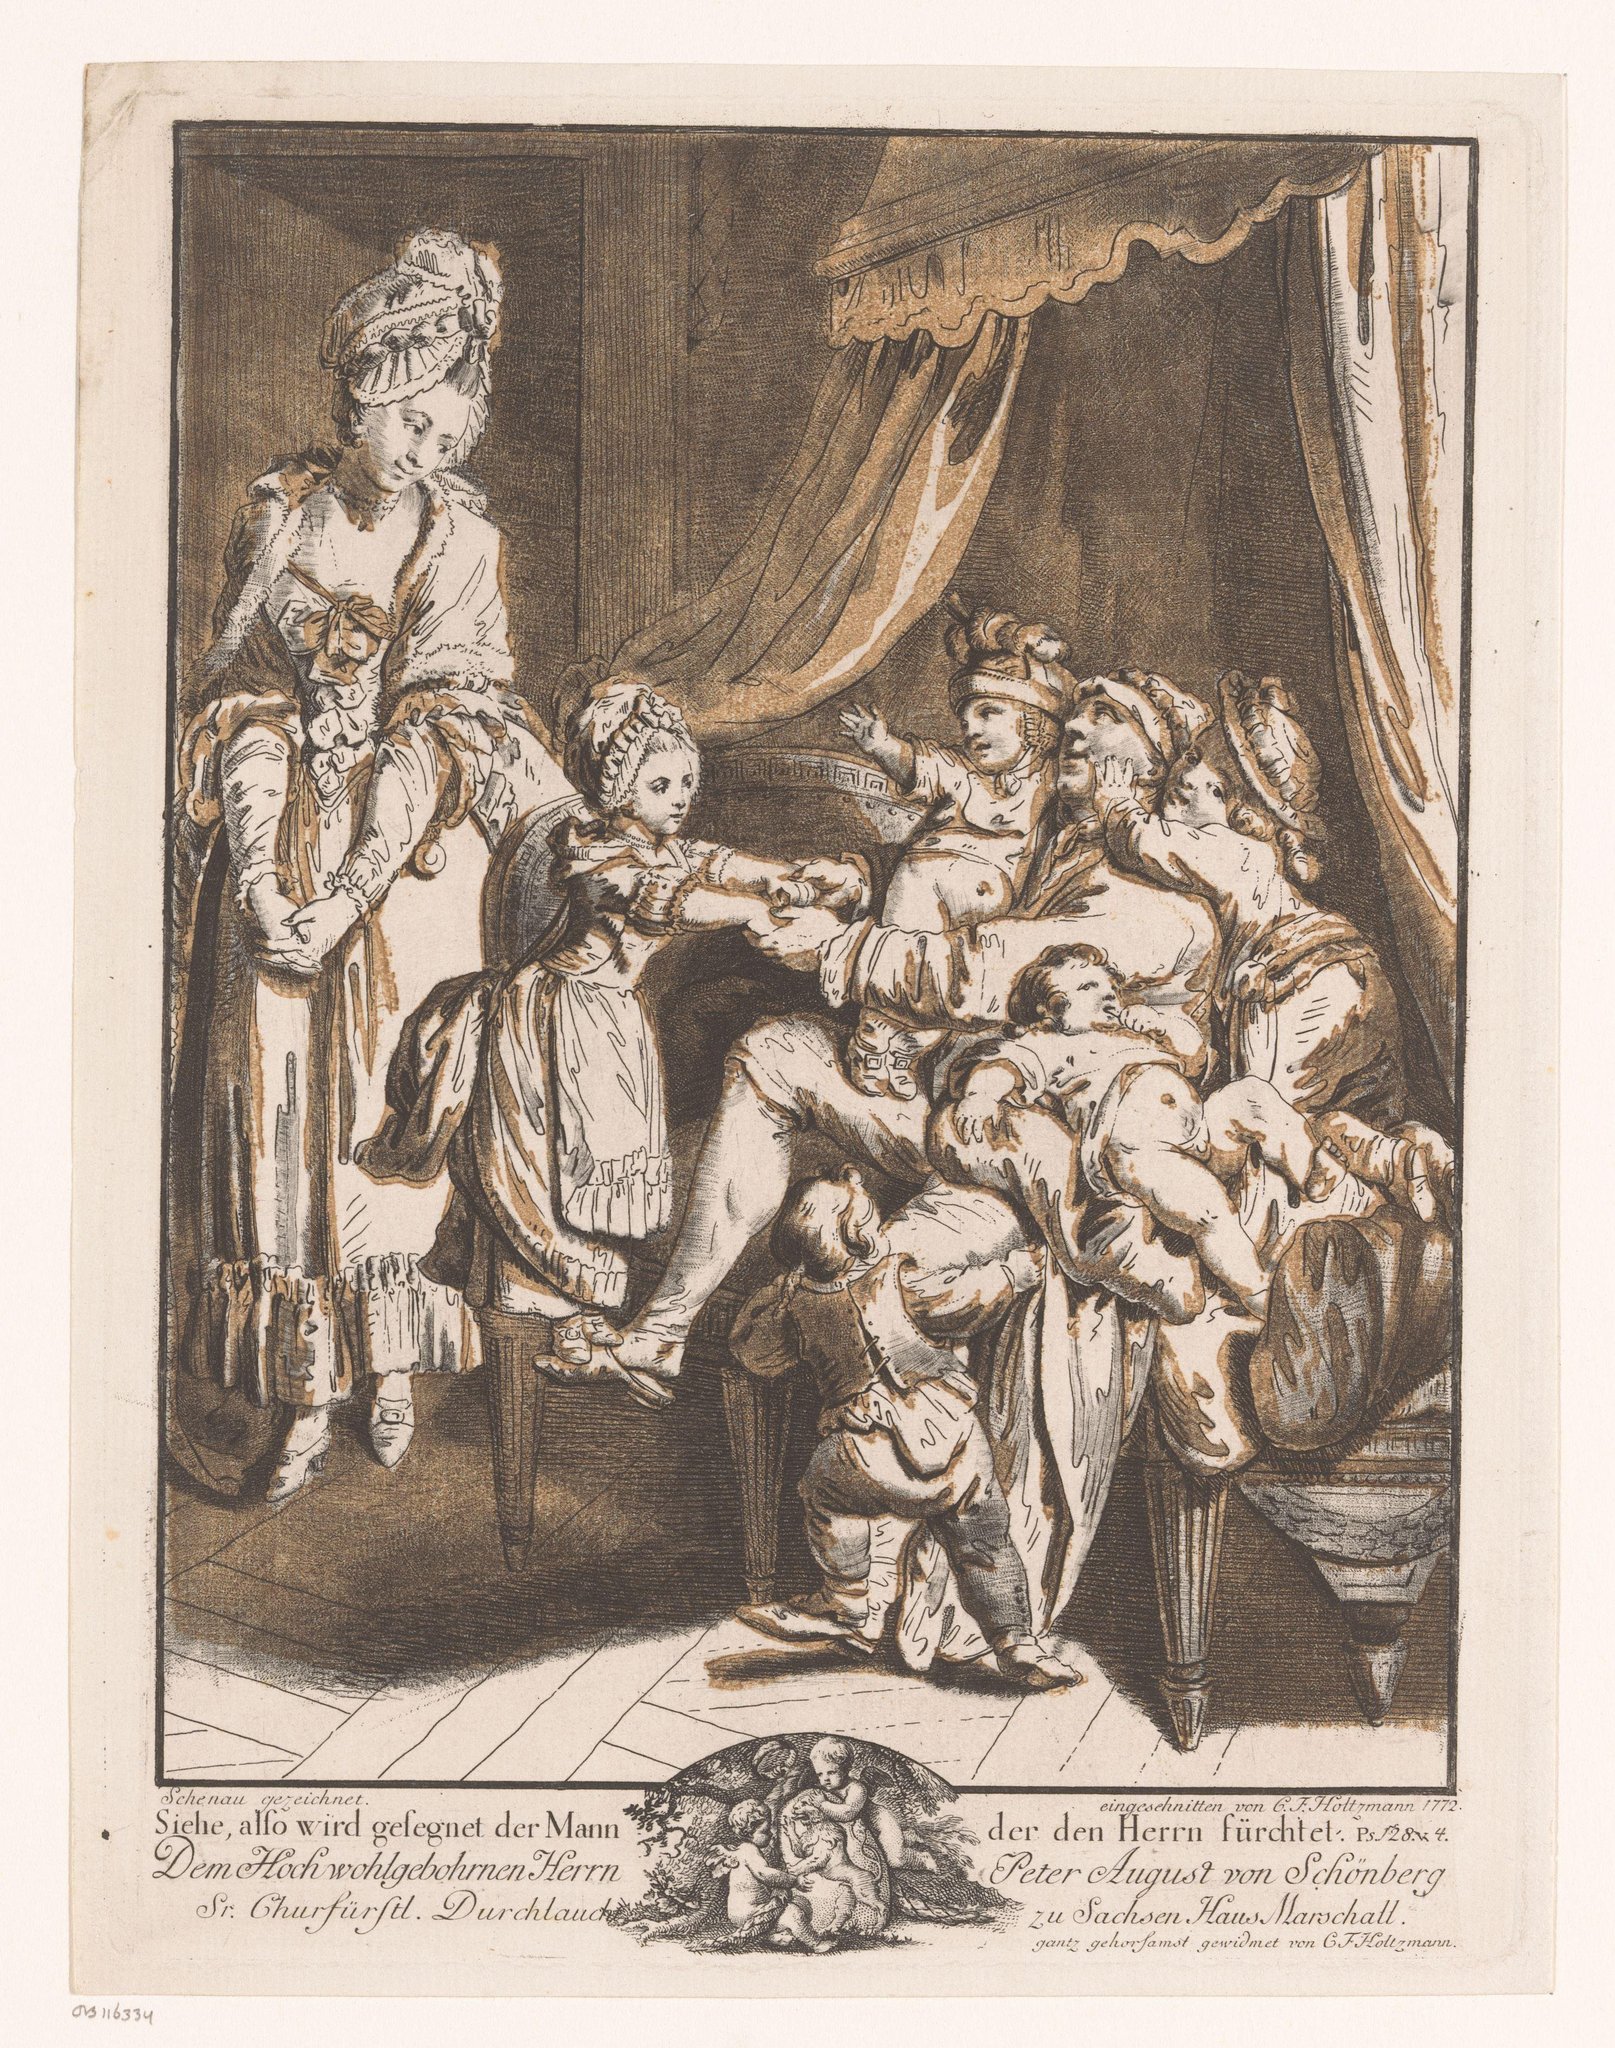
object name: print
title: Man op een bank omringd door vijf kinderen terwijl zijn vrouw naast hem staat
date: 1772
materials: paper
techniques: aquatint, etching, intaglio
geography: dresden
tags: the book of psalms (with book chapter:verse), family group, especially parents with their child(ren), ornament ~ medallion, cupids: 'amores', 'amoretti', 'putti'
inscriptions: collector's mark: Lugt 240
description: Onder de voorstelling een éénregelige tekst uit Psalm 128:4 en de opdracht in het Duits.